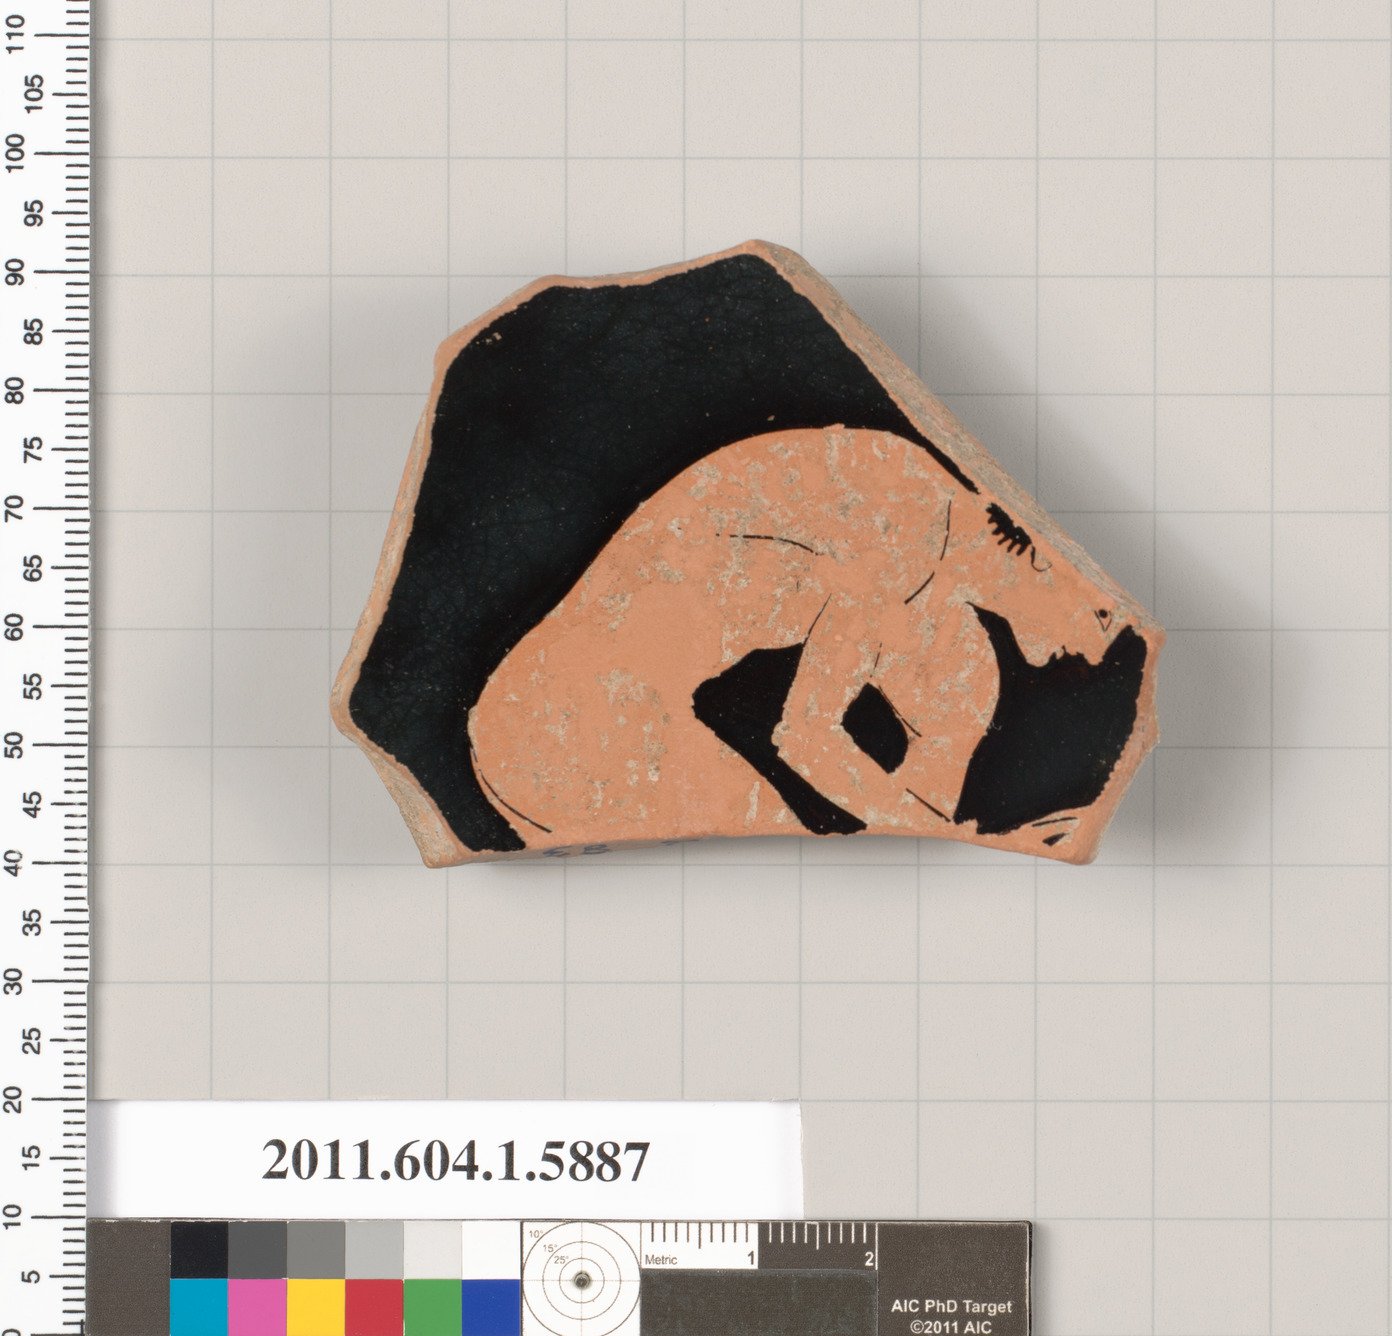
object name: kylix fragment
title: Terracotta fragment of a kylix (drinking cup)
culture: greek, attic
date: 520-510 BCE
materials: terracotta